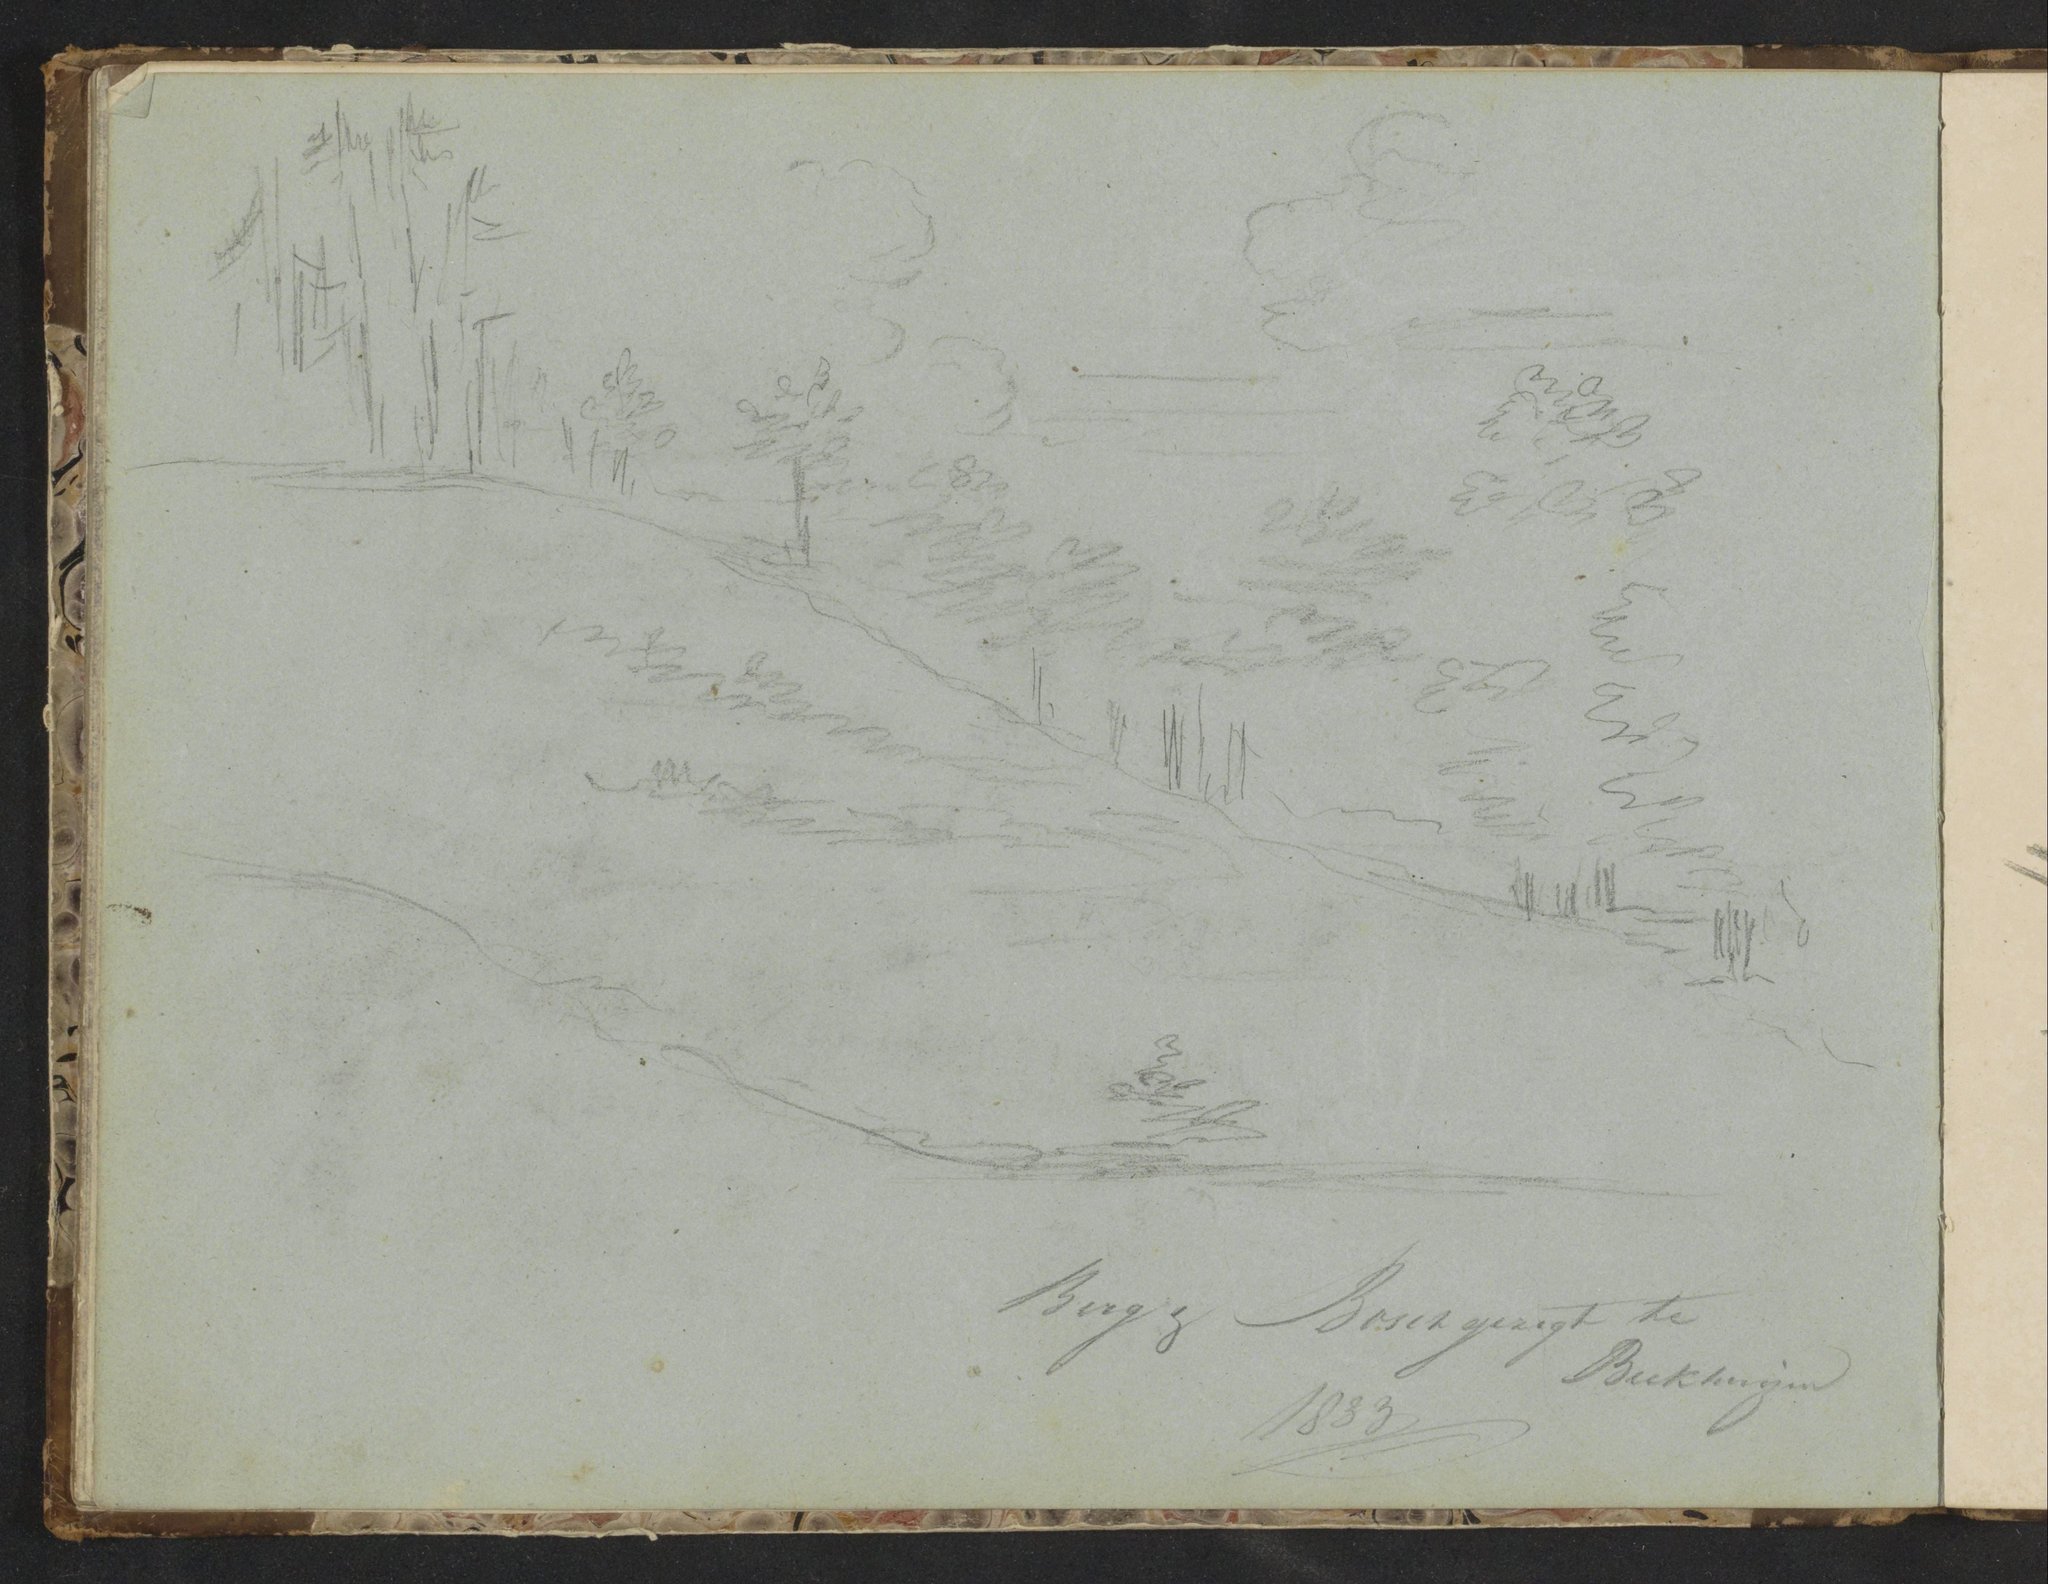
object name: sketchbook leaf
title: Bos- en berglandschap te Beekhuizen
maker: johannes tavenraat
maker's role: draughtsman, painter, print maker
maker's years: 1809-1881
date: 1833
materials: paper, pencil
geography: gelderland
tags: low hill country, forest, wood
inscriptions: date and inscription: ‘Berg & Bosch gezigt te/ Beekhuizen/ 1833’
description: Blad 9 verso uit een schetsboek met 41 bladen.